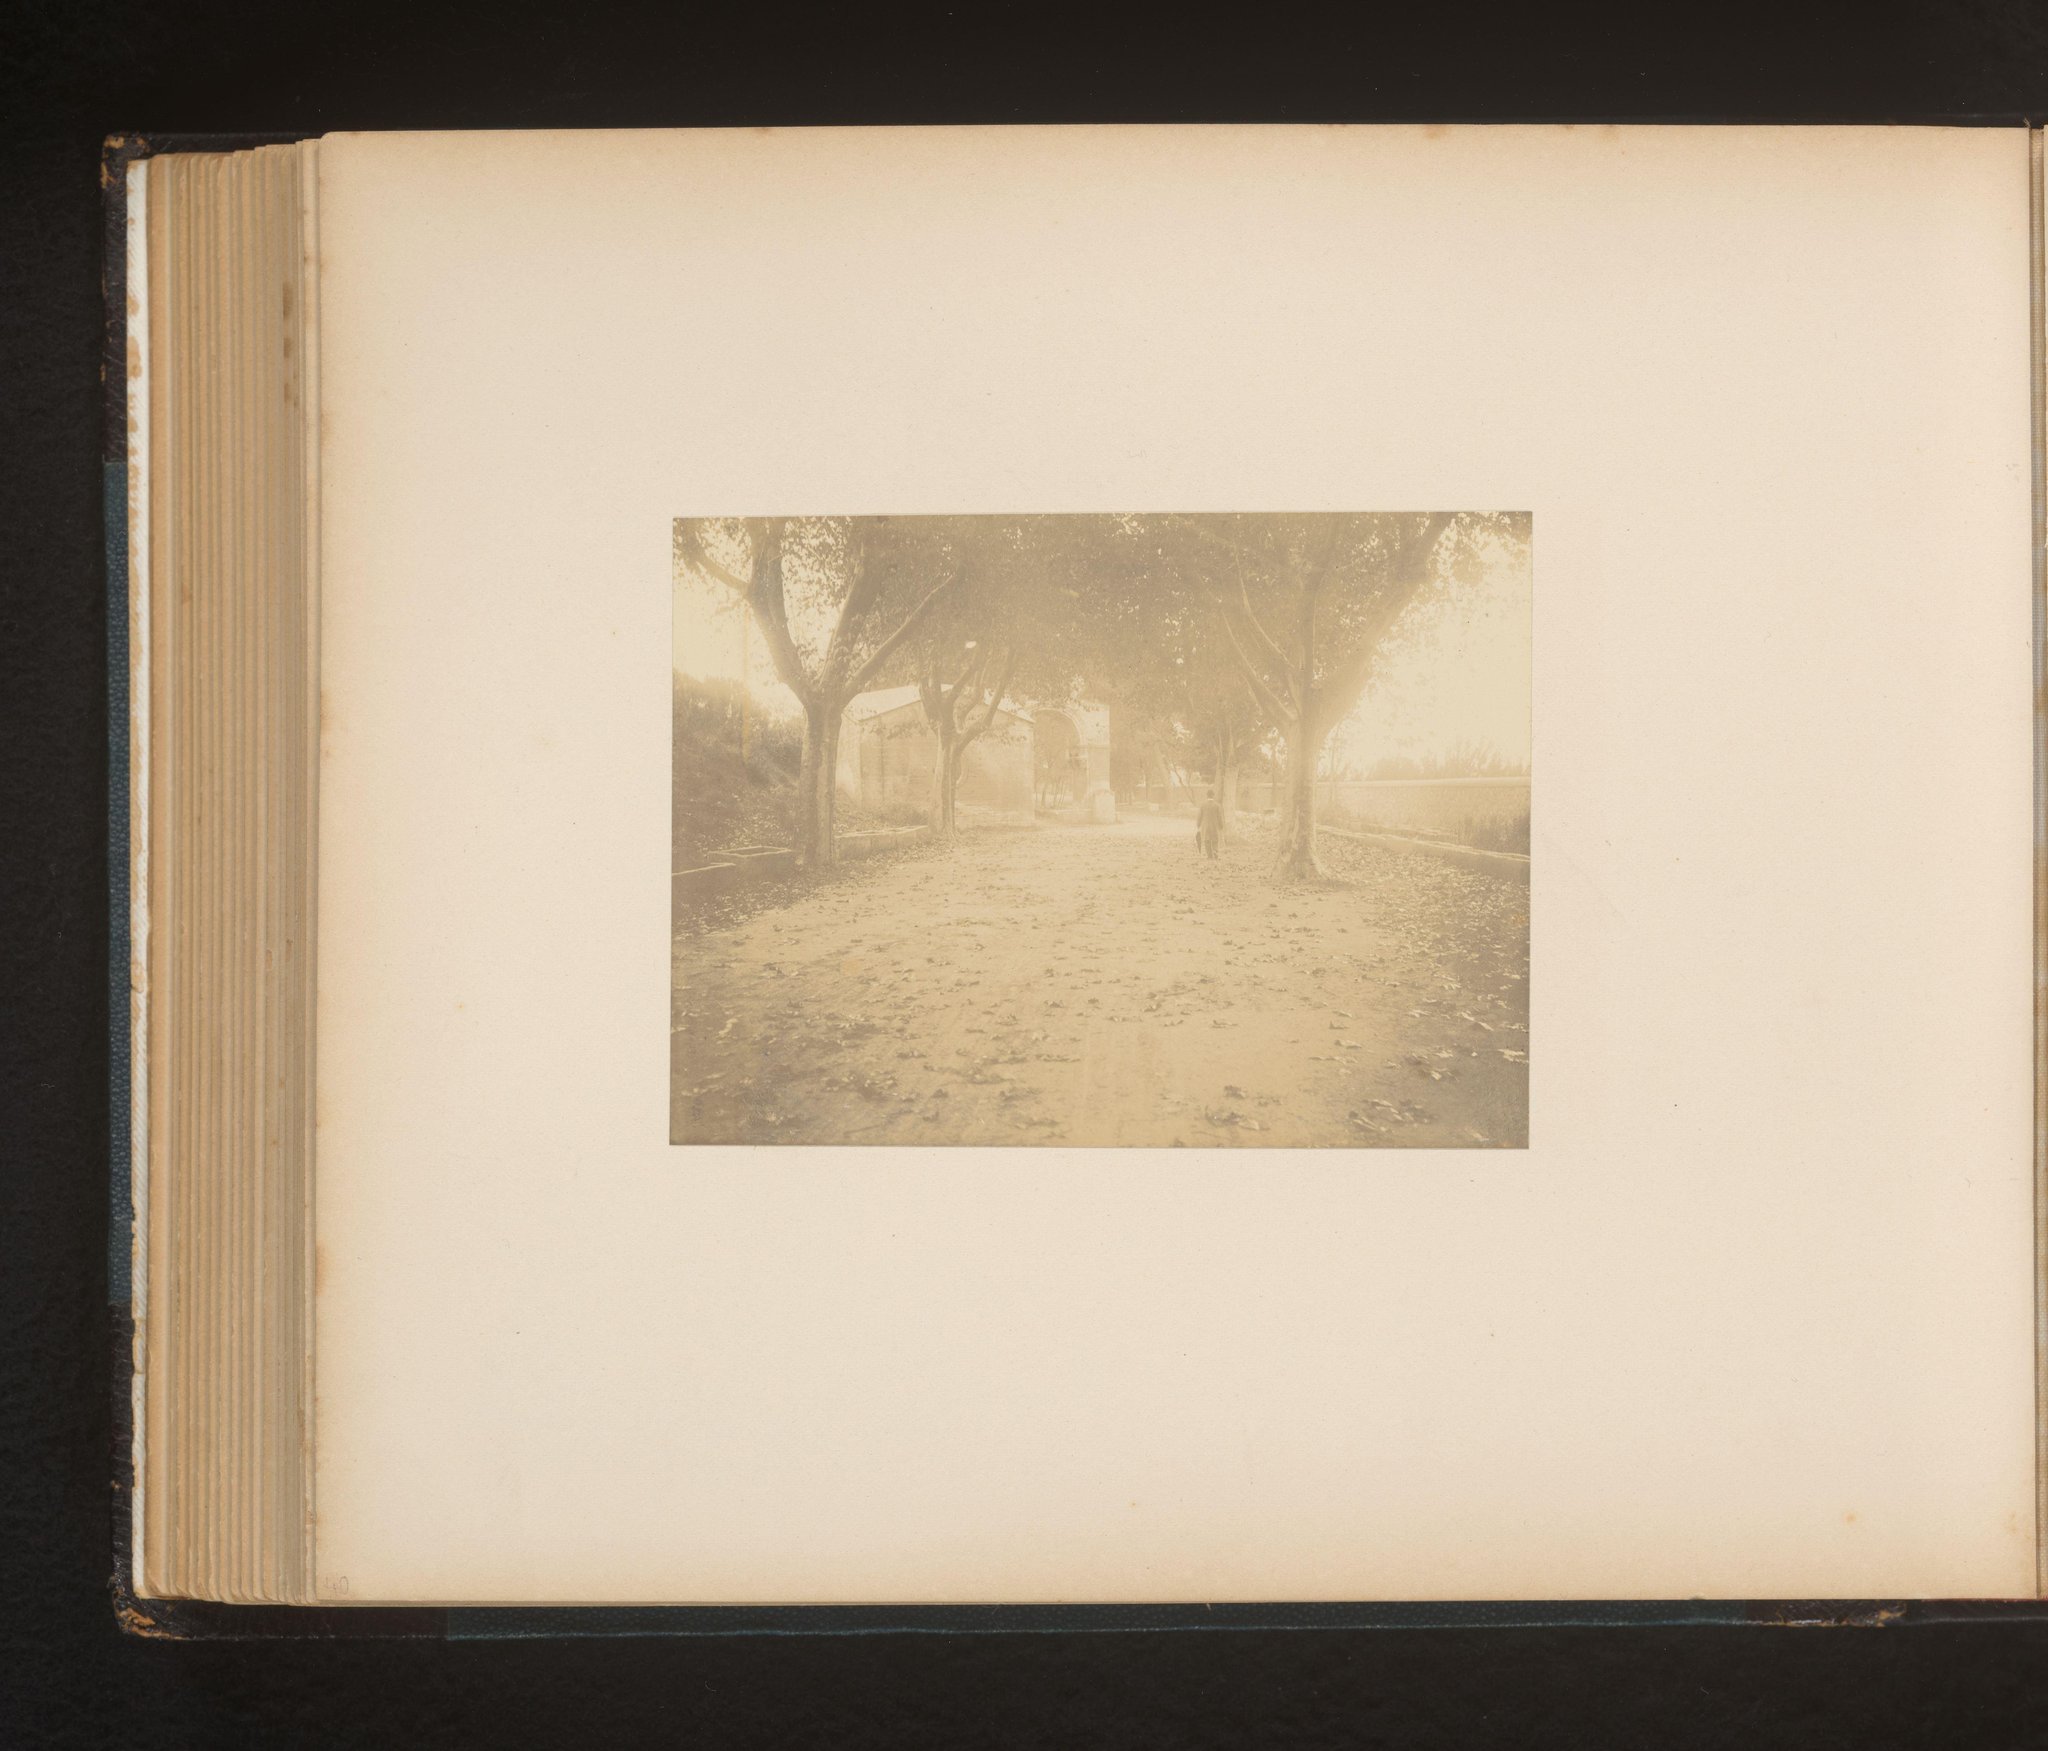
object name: album leaf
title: Alyscamps te Arles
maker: Anonymous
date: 1880-1920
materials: cardboard, photographic support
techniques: gelatin silver print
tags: trees, necropolis, historical persons